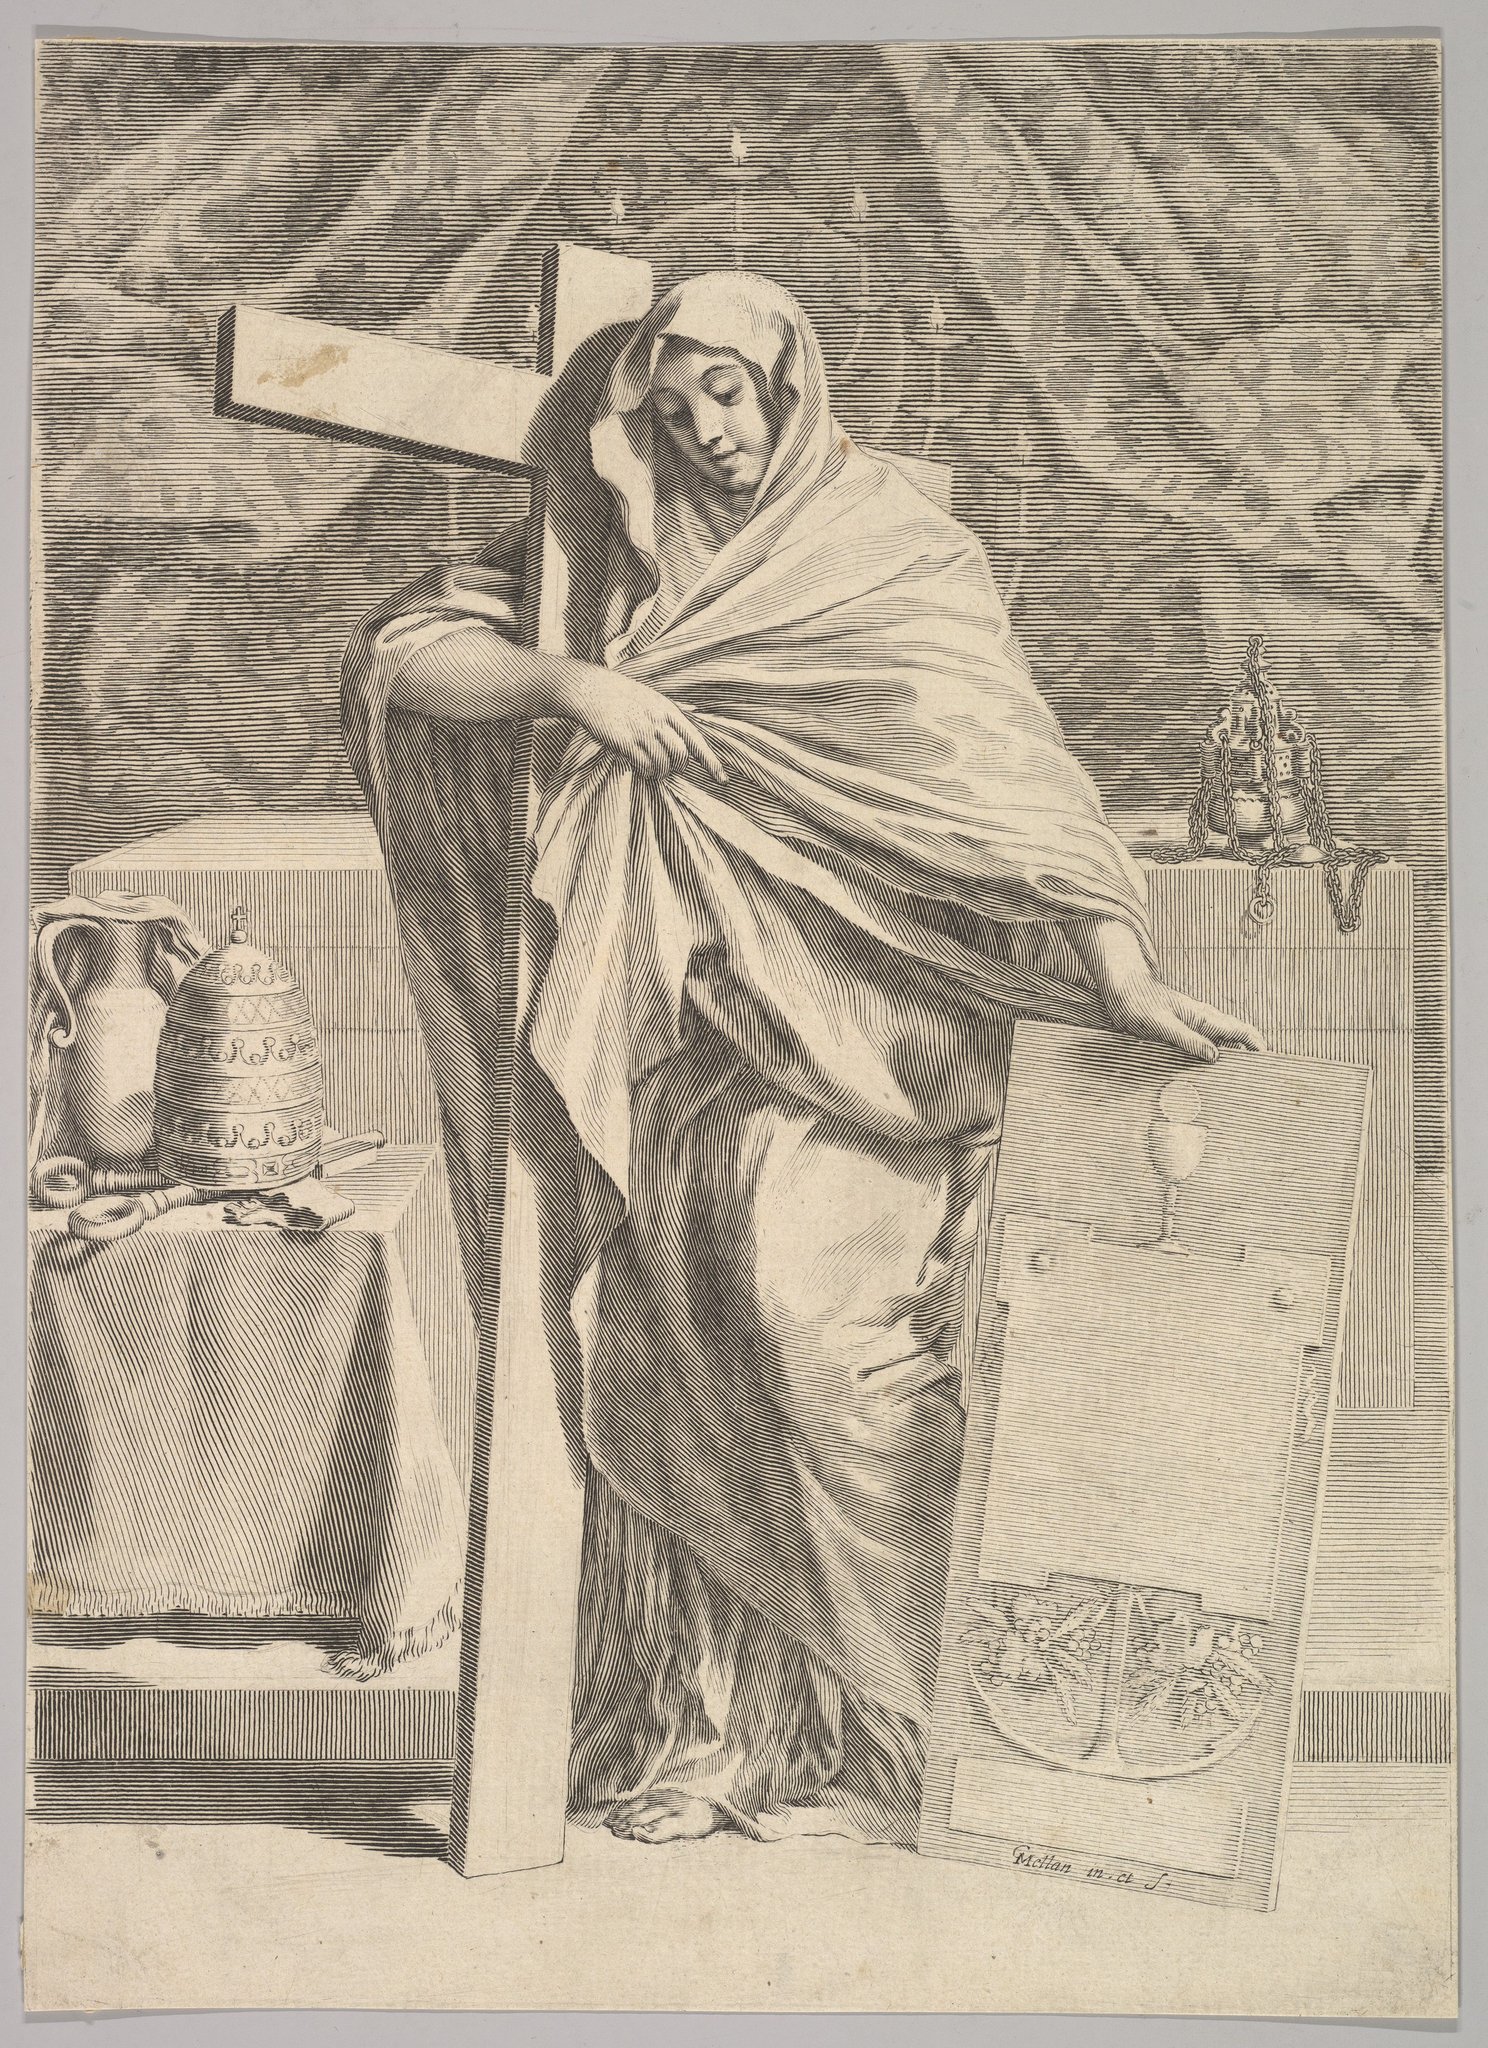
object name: print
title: Personification of Faith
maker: claude mellan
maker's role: artist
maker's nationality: french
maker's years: 1598-1688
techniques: engraving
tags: women,cross,censers